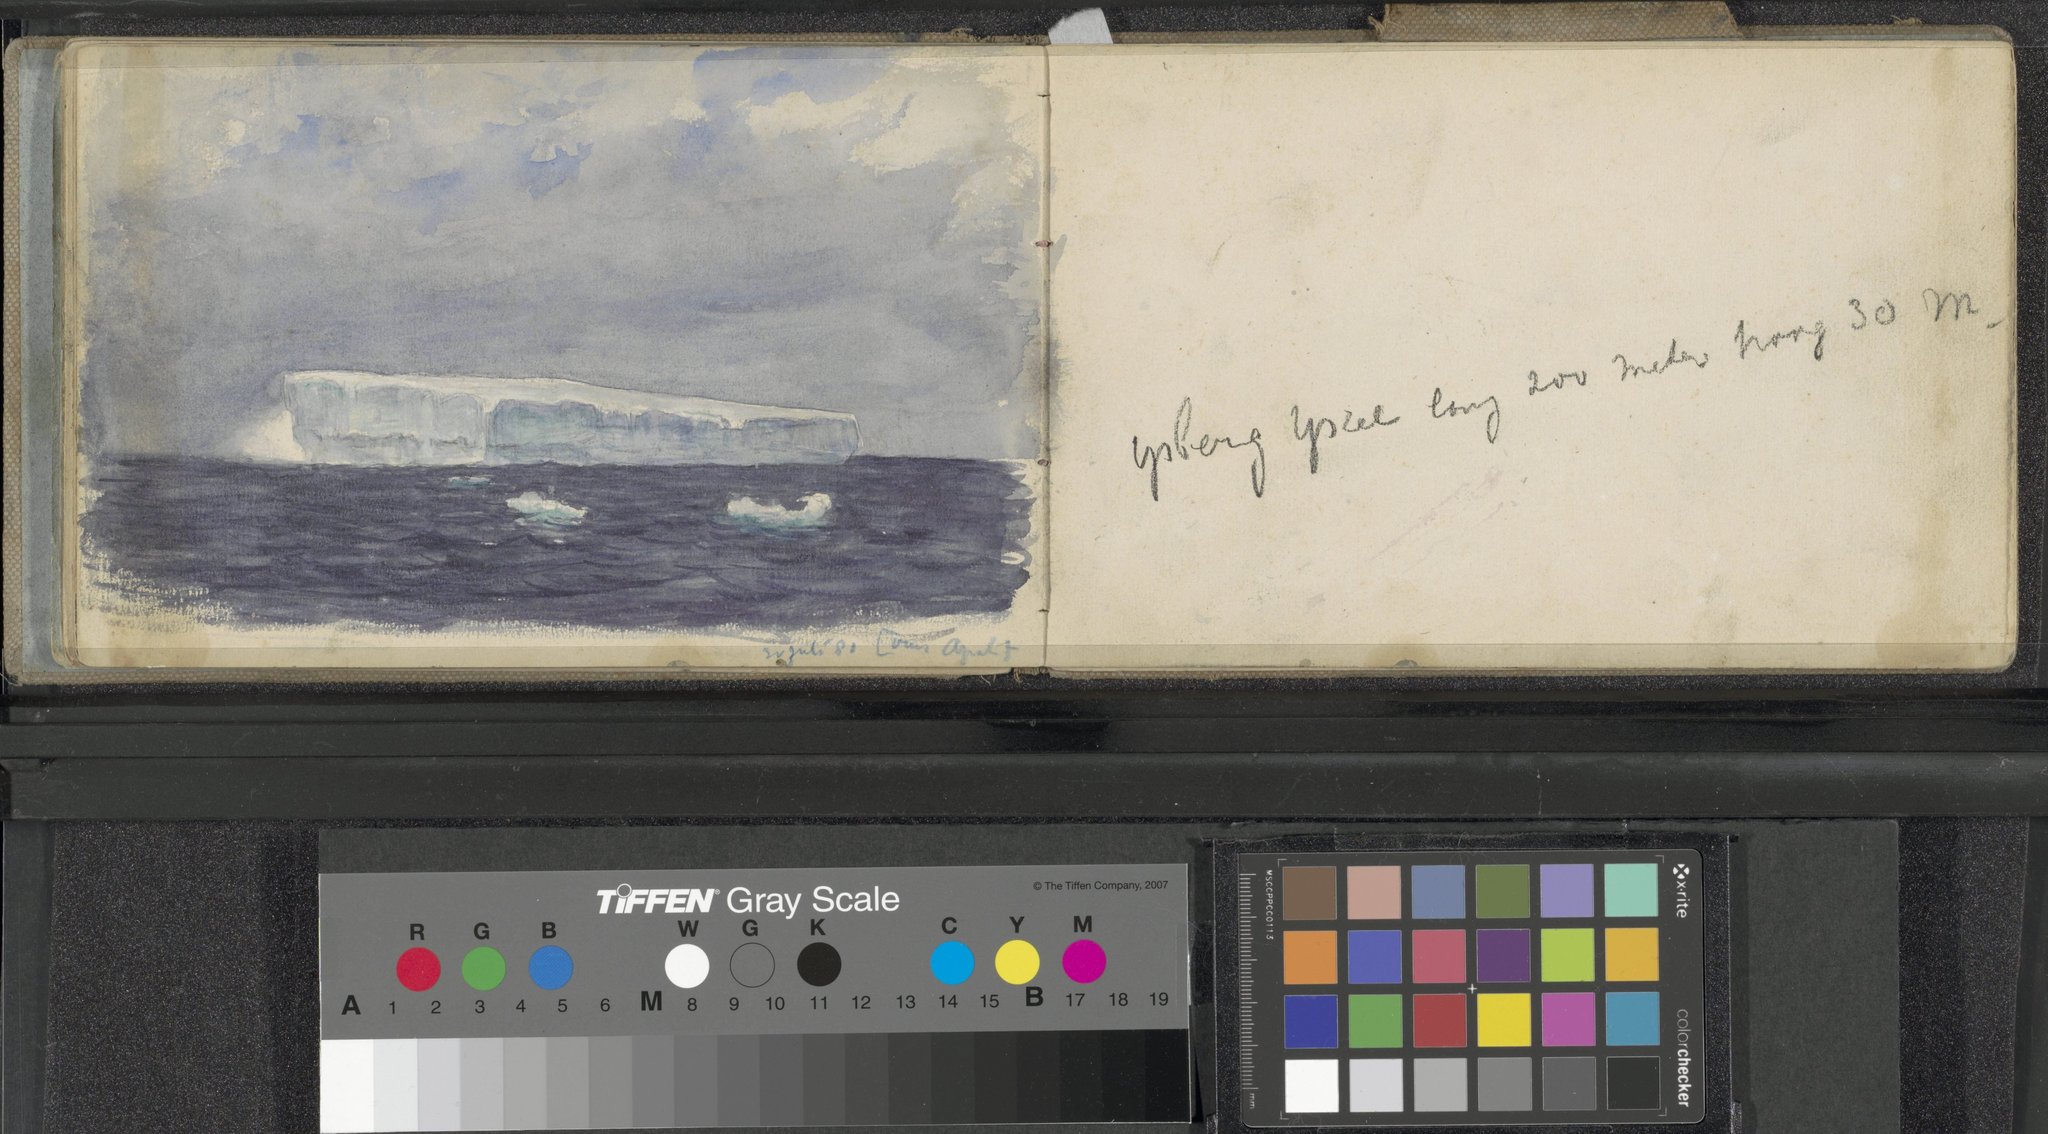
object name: sketchbook leaf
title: Gezicht op een ijsberg in de Noordelijke IJszee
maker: louis apol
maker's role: draughtsman, painter, print maker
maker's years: 1850-1936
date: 1880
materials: paper, pencil, watercolor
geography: arctic ocean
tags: iceberg, sea (seascape)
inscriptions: signature: ‘Louis Apol f’, annotation: ‘30 [31?] juli '80’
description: De ijsberg mat 200 bij 30 meter. Blad 26 verso uit een schetsboek met 35 bladen betekend tijdens de expeditie naar Nova Zembla in 1880.